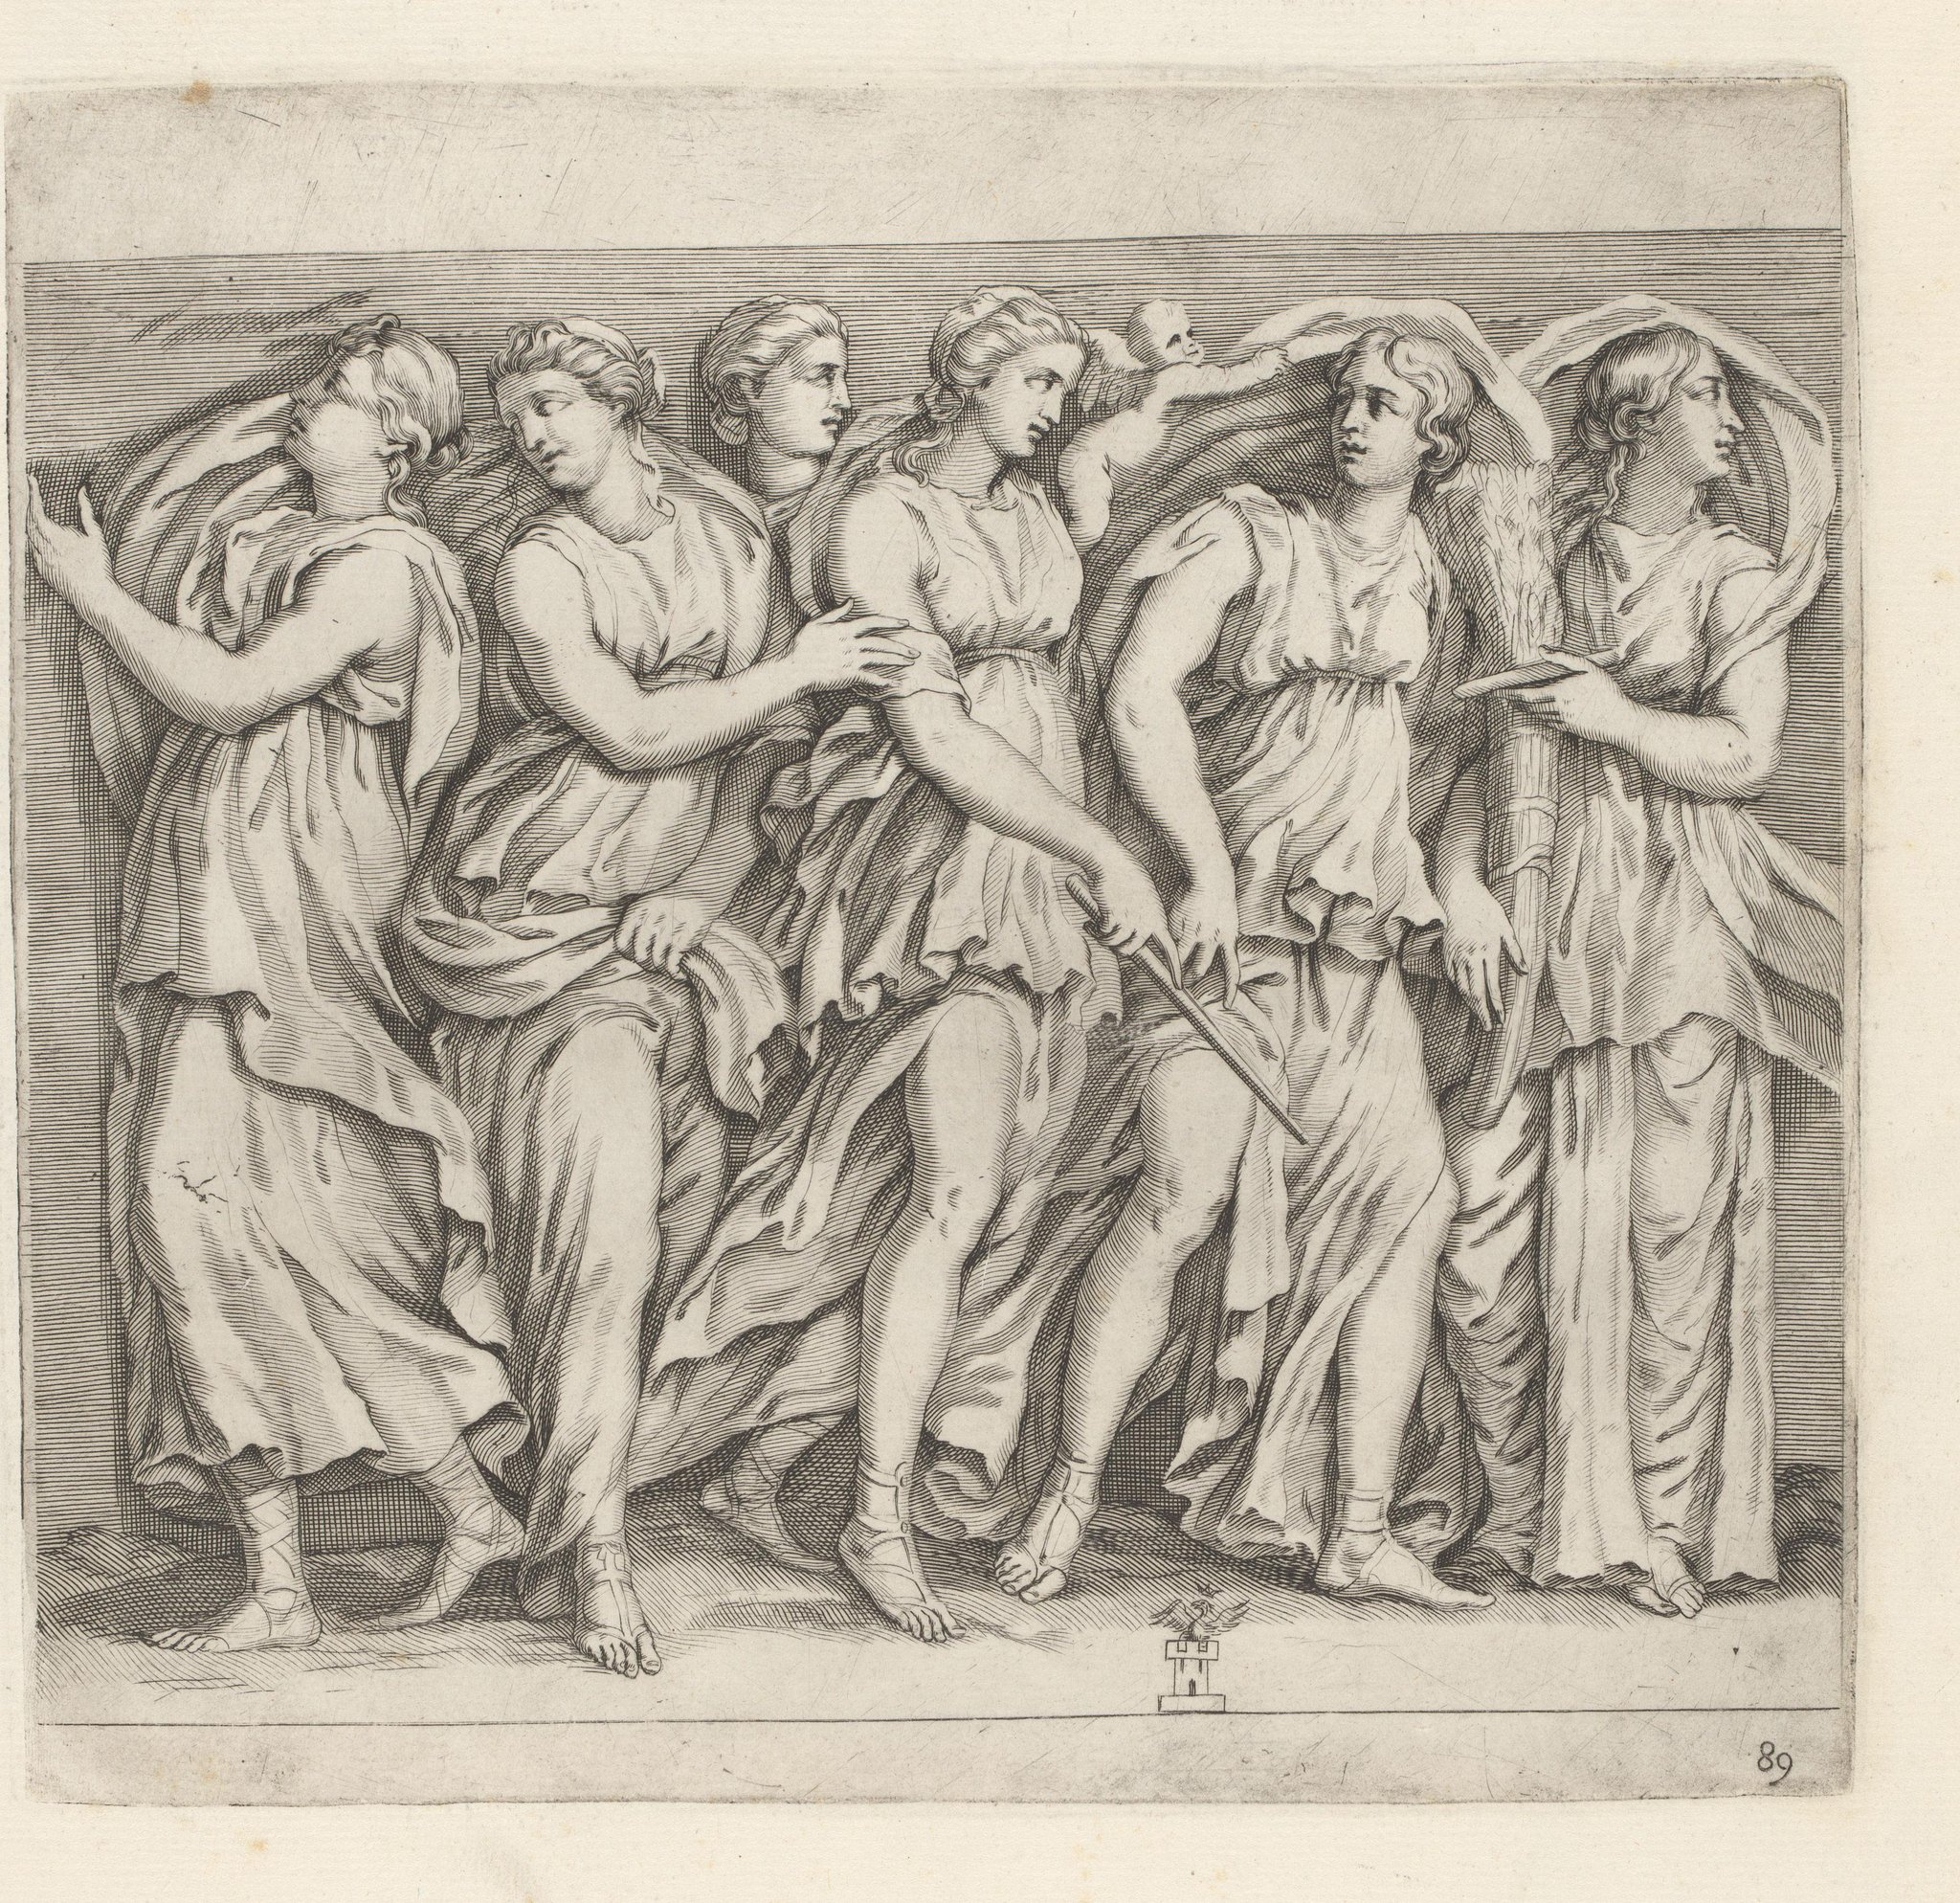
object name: album leaf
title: Galleria Giustiniana del Marchese Vincenzo Giustiniani II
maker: gabriel ladame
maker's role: print maker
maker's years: 1613-1679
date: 1636-1647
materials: paper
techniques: engraving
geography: rome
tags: piece of sculpture, reproduction of a piece of sculpture, female persons from classical history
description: Bas-reliëf met zes vrouwen. De rechtervrouw heeft een korenschoof in haar armen. Midden onder het wapenschild van Vincenzo Giustiniani. Prent maakt deel uit van een album met een serie prenten naar de sculpturen in de verzameling in de Galleria Giustiniani te Rome.